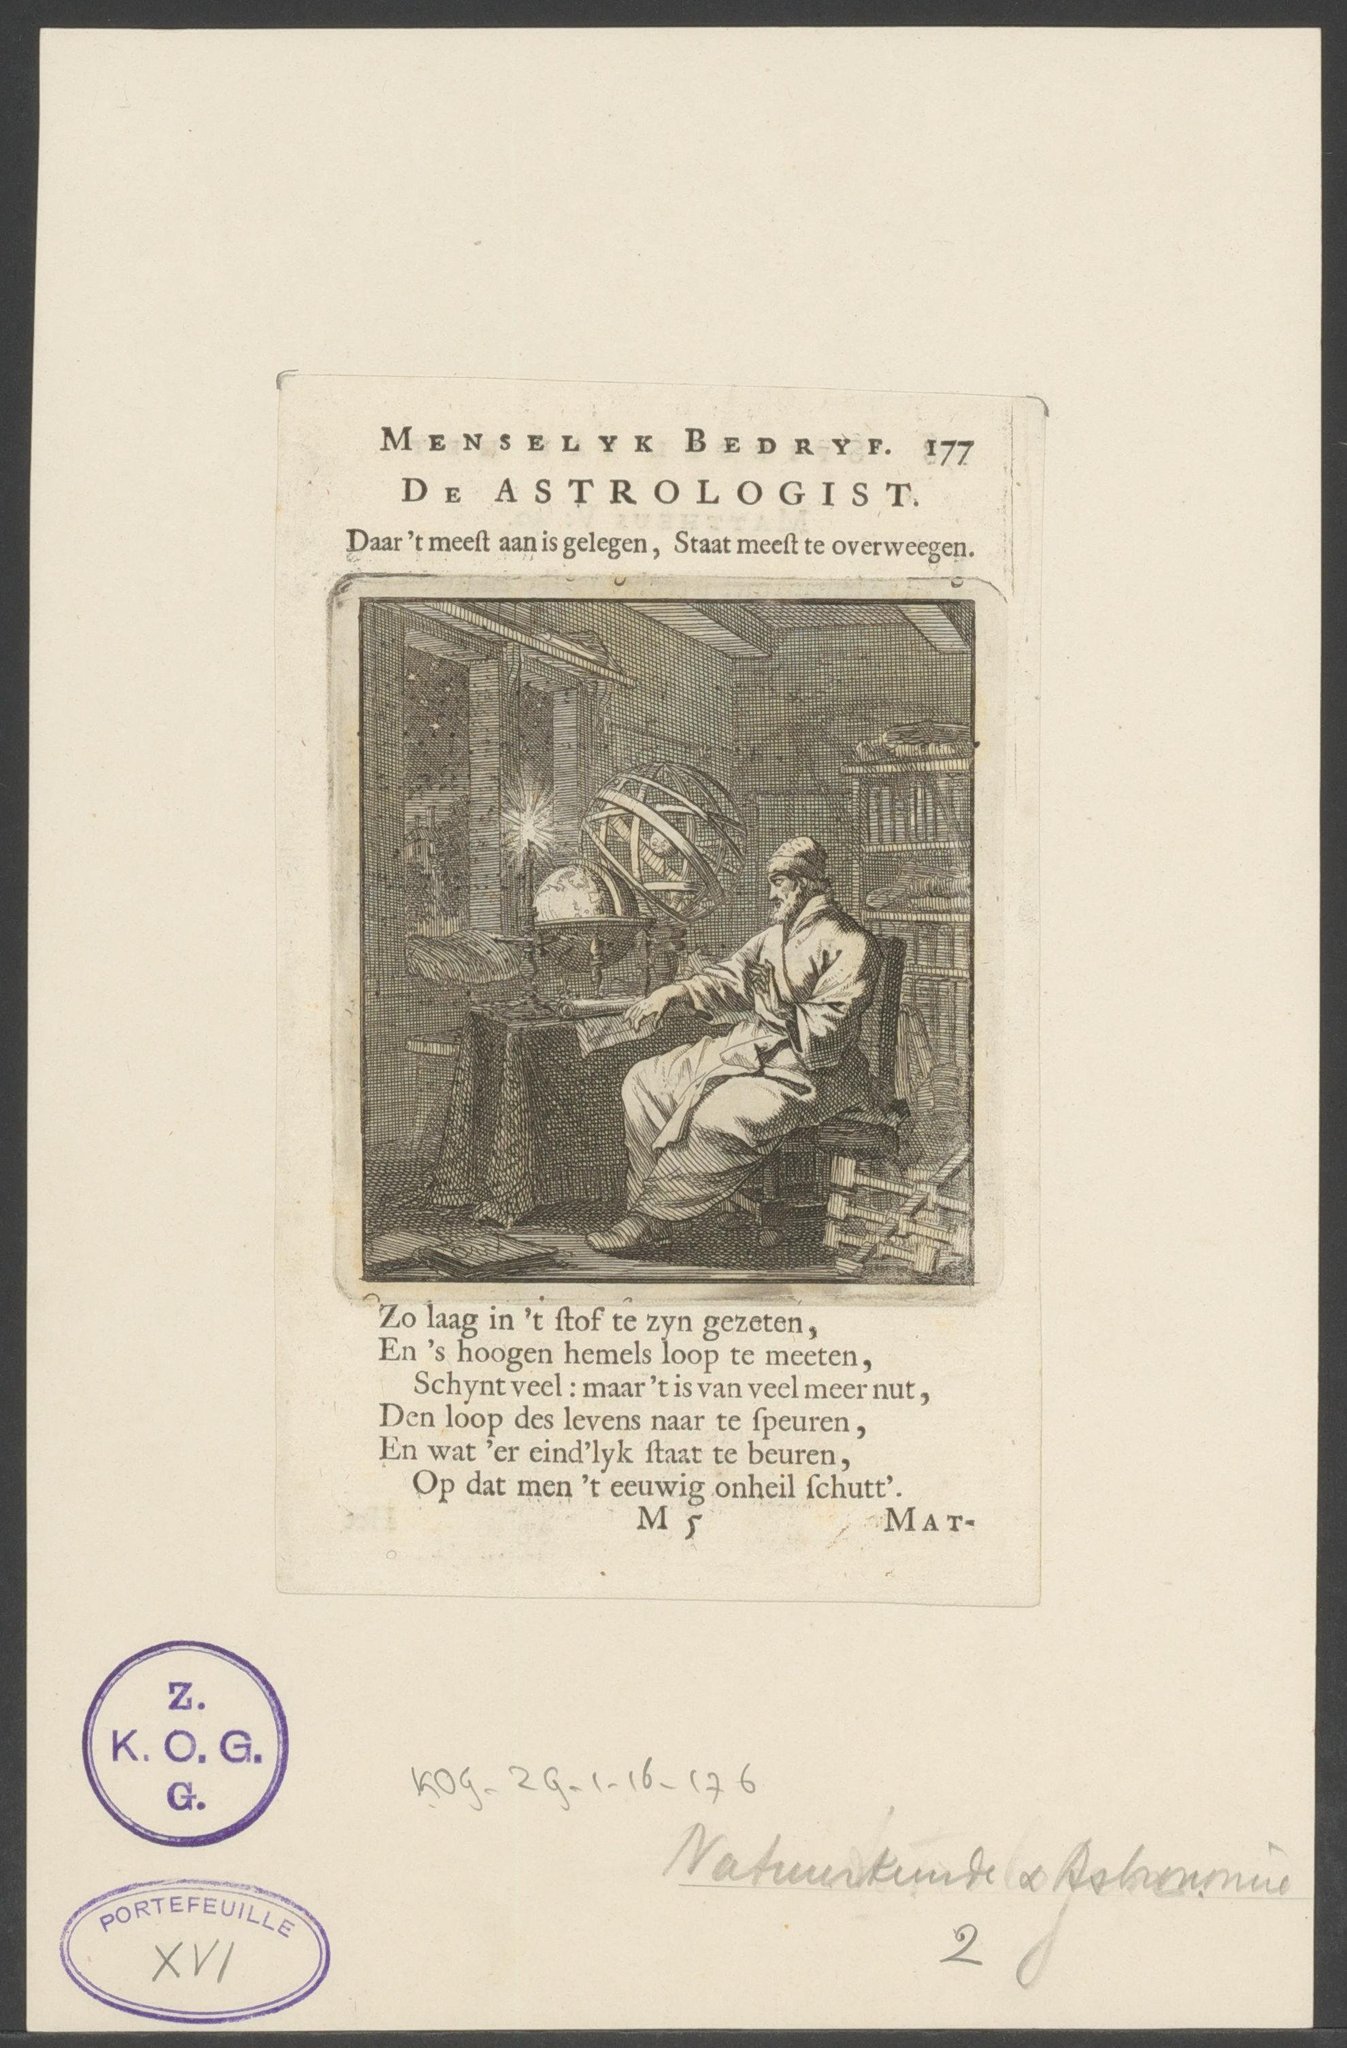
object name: print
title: Astroloog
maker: cornelis van der sys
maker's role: publisher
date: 1718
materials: paper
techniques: etching, letterpress printing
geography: amsterdam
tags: astronomical instruments, astronomy (and cosmography)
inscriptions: collector's mark: Lugt 1641, stamp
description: Prent oorspronkelijk verschenen in de 100-delige serie beroepsprenten van Jan en Caspar Luyken, getiteld: Het menselyk bedryf. S.l.s.n., 1694 (eerste druk). Daarna is de titel en het vers afgesneden. De prenten in diverse publicaties verschenen en gekopieerd. Huidige staat uit: Luyken, Jan en Caspar. Spiegel van het menselyk bedryf (...). Amsterdam: Cornelis van der Sys, 1718, p. 177. Prent waarschijnlijk ook gebruikt in eerdere (1704) en latere (1730, 1749, 1767) publicaties.